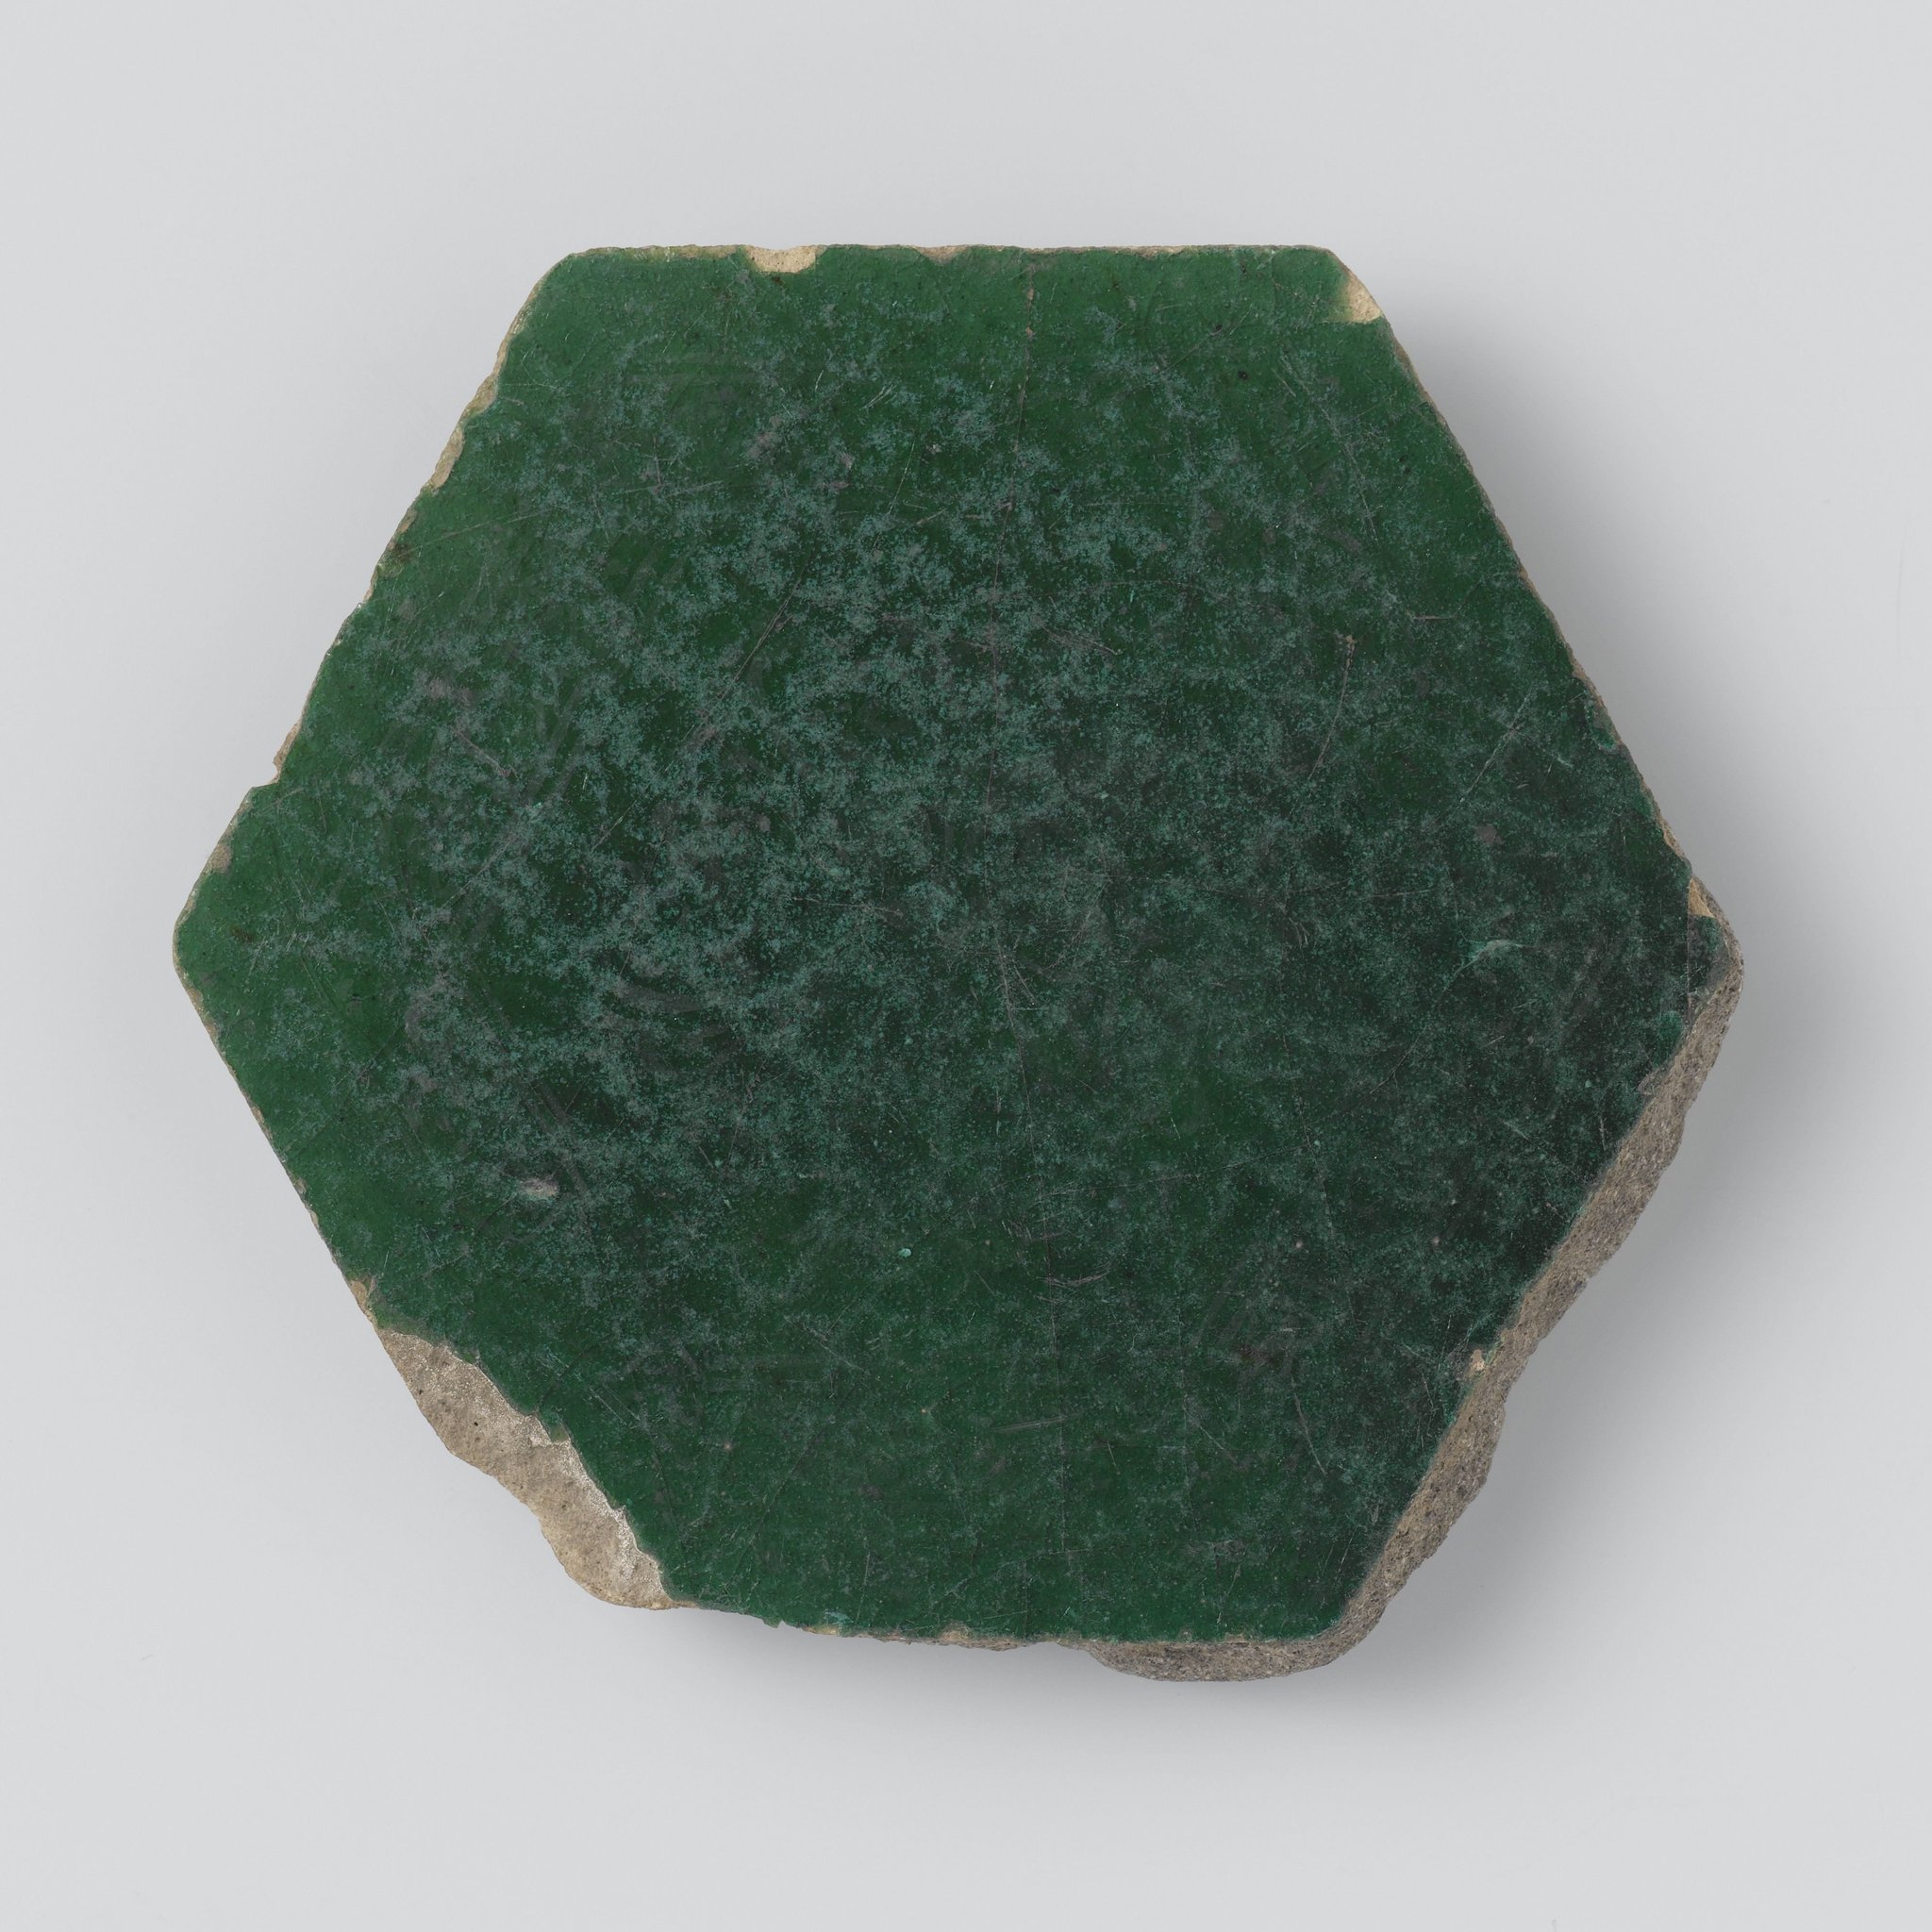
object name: tile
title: Hexagonal tile with a green glaze and inscription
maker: Anonymous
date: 1400-1599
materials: earthenware, glaze, luster, paint, quartz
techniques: firing, forming, vitrification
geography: turkey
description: Zeskhoekige tegel van kwarts-fritgoed. Op een grond van dik groen glazuur is een met de omtrek evenwijdige rand in luster aangebracht, waarin een inscriptie in arabische karakters: 'In den naam van Allah, barmhartig en mededogend. Allah is één. Hij is de God tot wie alle wezens zich richten met hun noden. Hij heeft niet verwekt en is niet verwekt. Hij heeft geen gelijke in wie ook.' (Koran kap 112). In het midden staan de namen van de Twaalf Imams. Afkomstig van het paleis van Selim II te Anetrinopel. De metaalglans is nagenoeg geheel dof geworden, zodat de inscripties slechts onder bepaalde lichtinval te zien zijn. Aan de hoeken beschadigd.